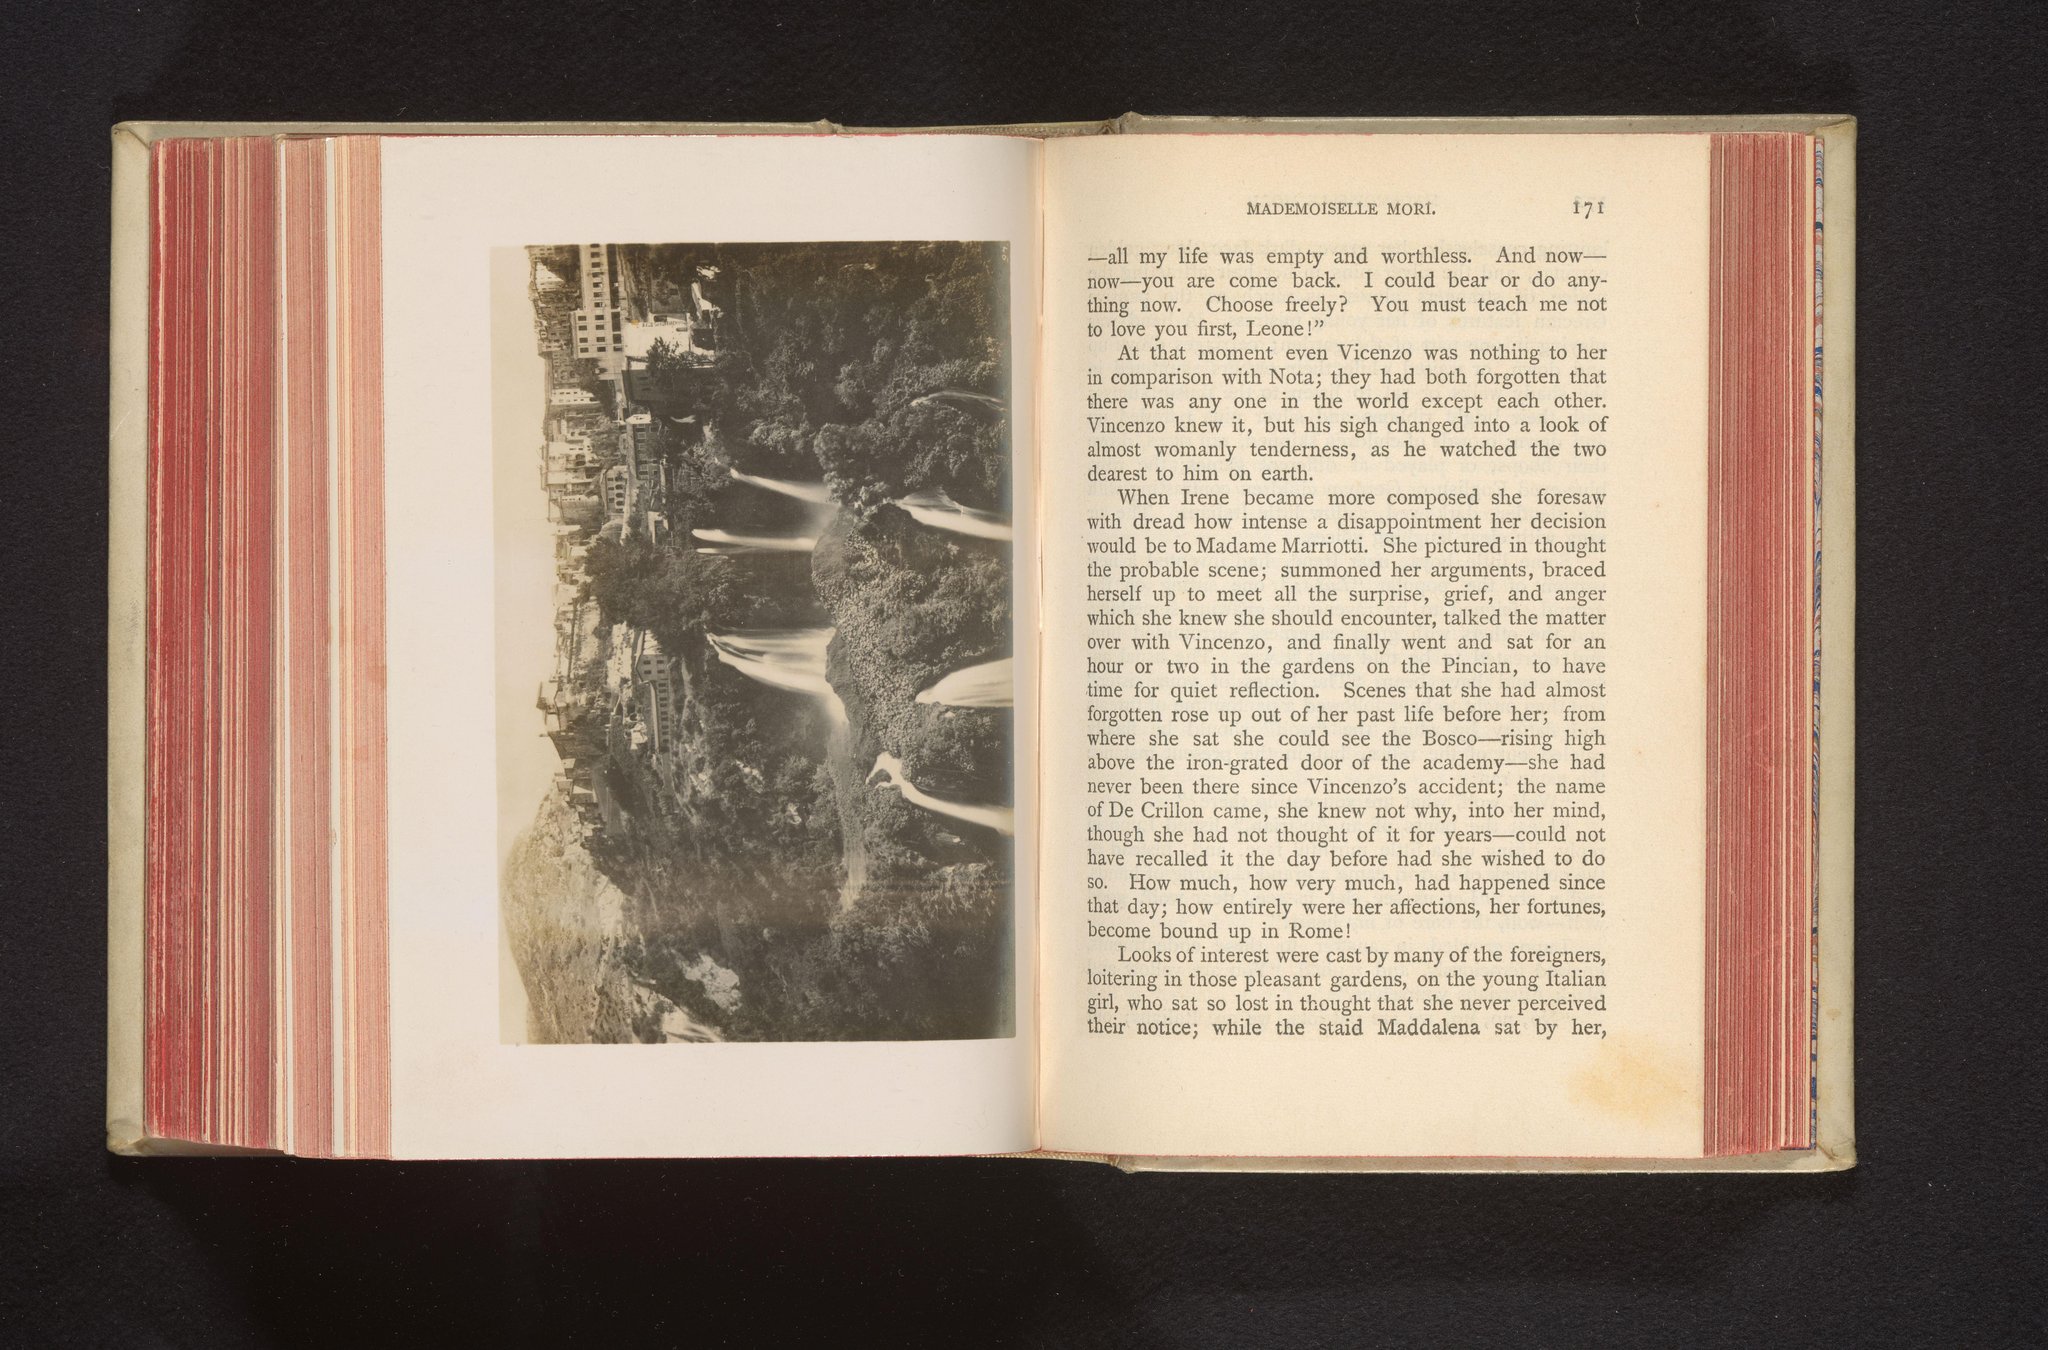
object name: page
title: Gezicht op de watervallen te Tivoli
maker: Anonymous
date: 1852-1862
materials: photographic support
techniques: gelatin silver print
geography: lazio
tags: waterfall, tivoli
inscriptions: number: ‘97.’